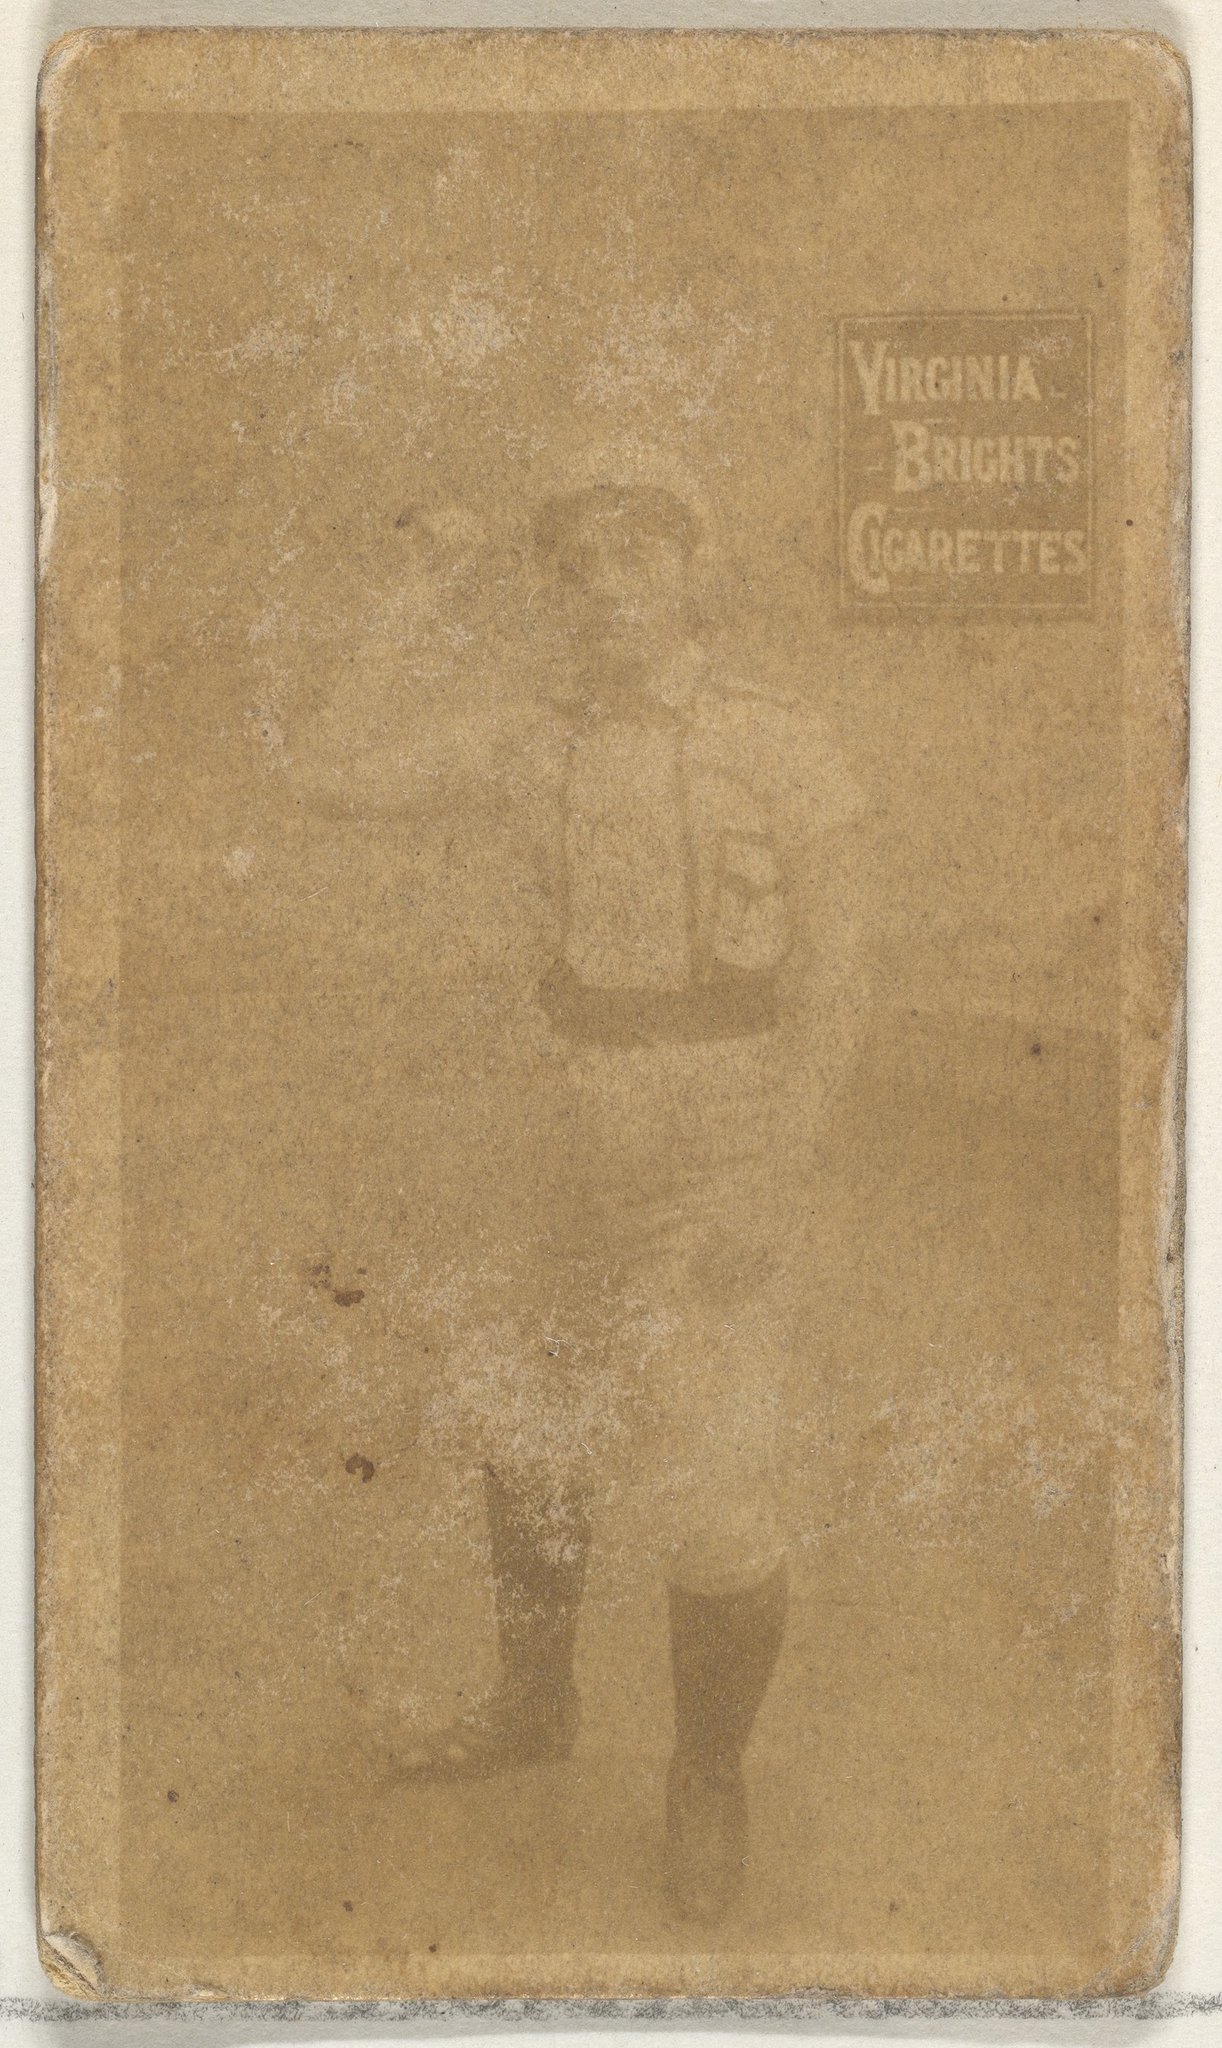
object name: baseball card, photograph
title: From the Girl Baseball Players series (N48, Type 2) for Virginia Brights Cigarettes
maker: allen & ginter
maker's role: publisher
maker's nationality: american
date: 1886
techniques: albumen silver print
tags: portraits,women,baseball,athletes